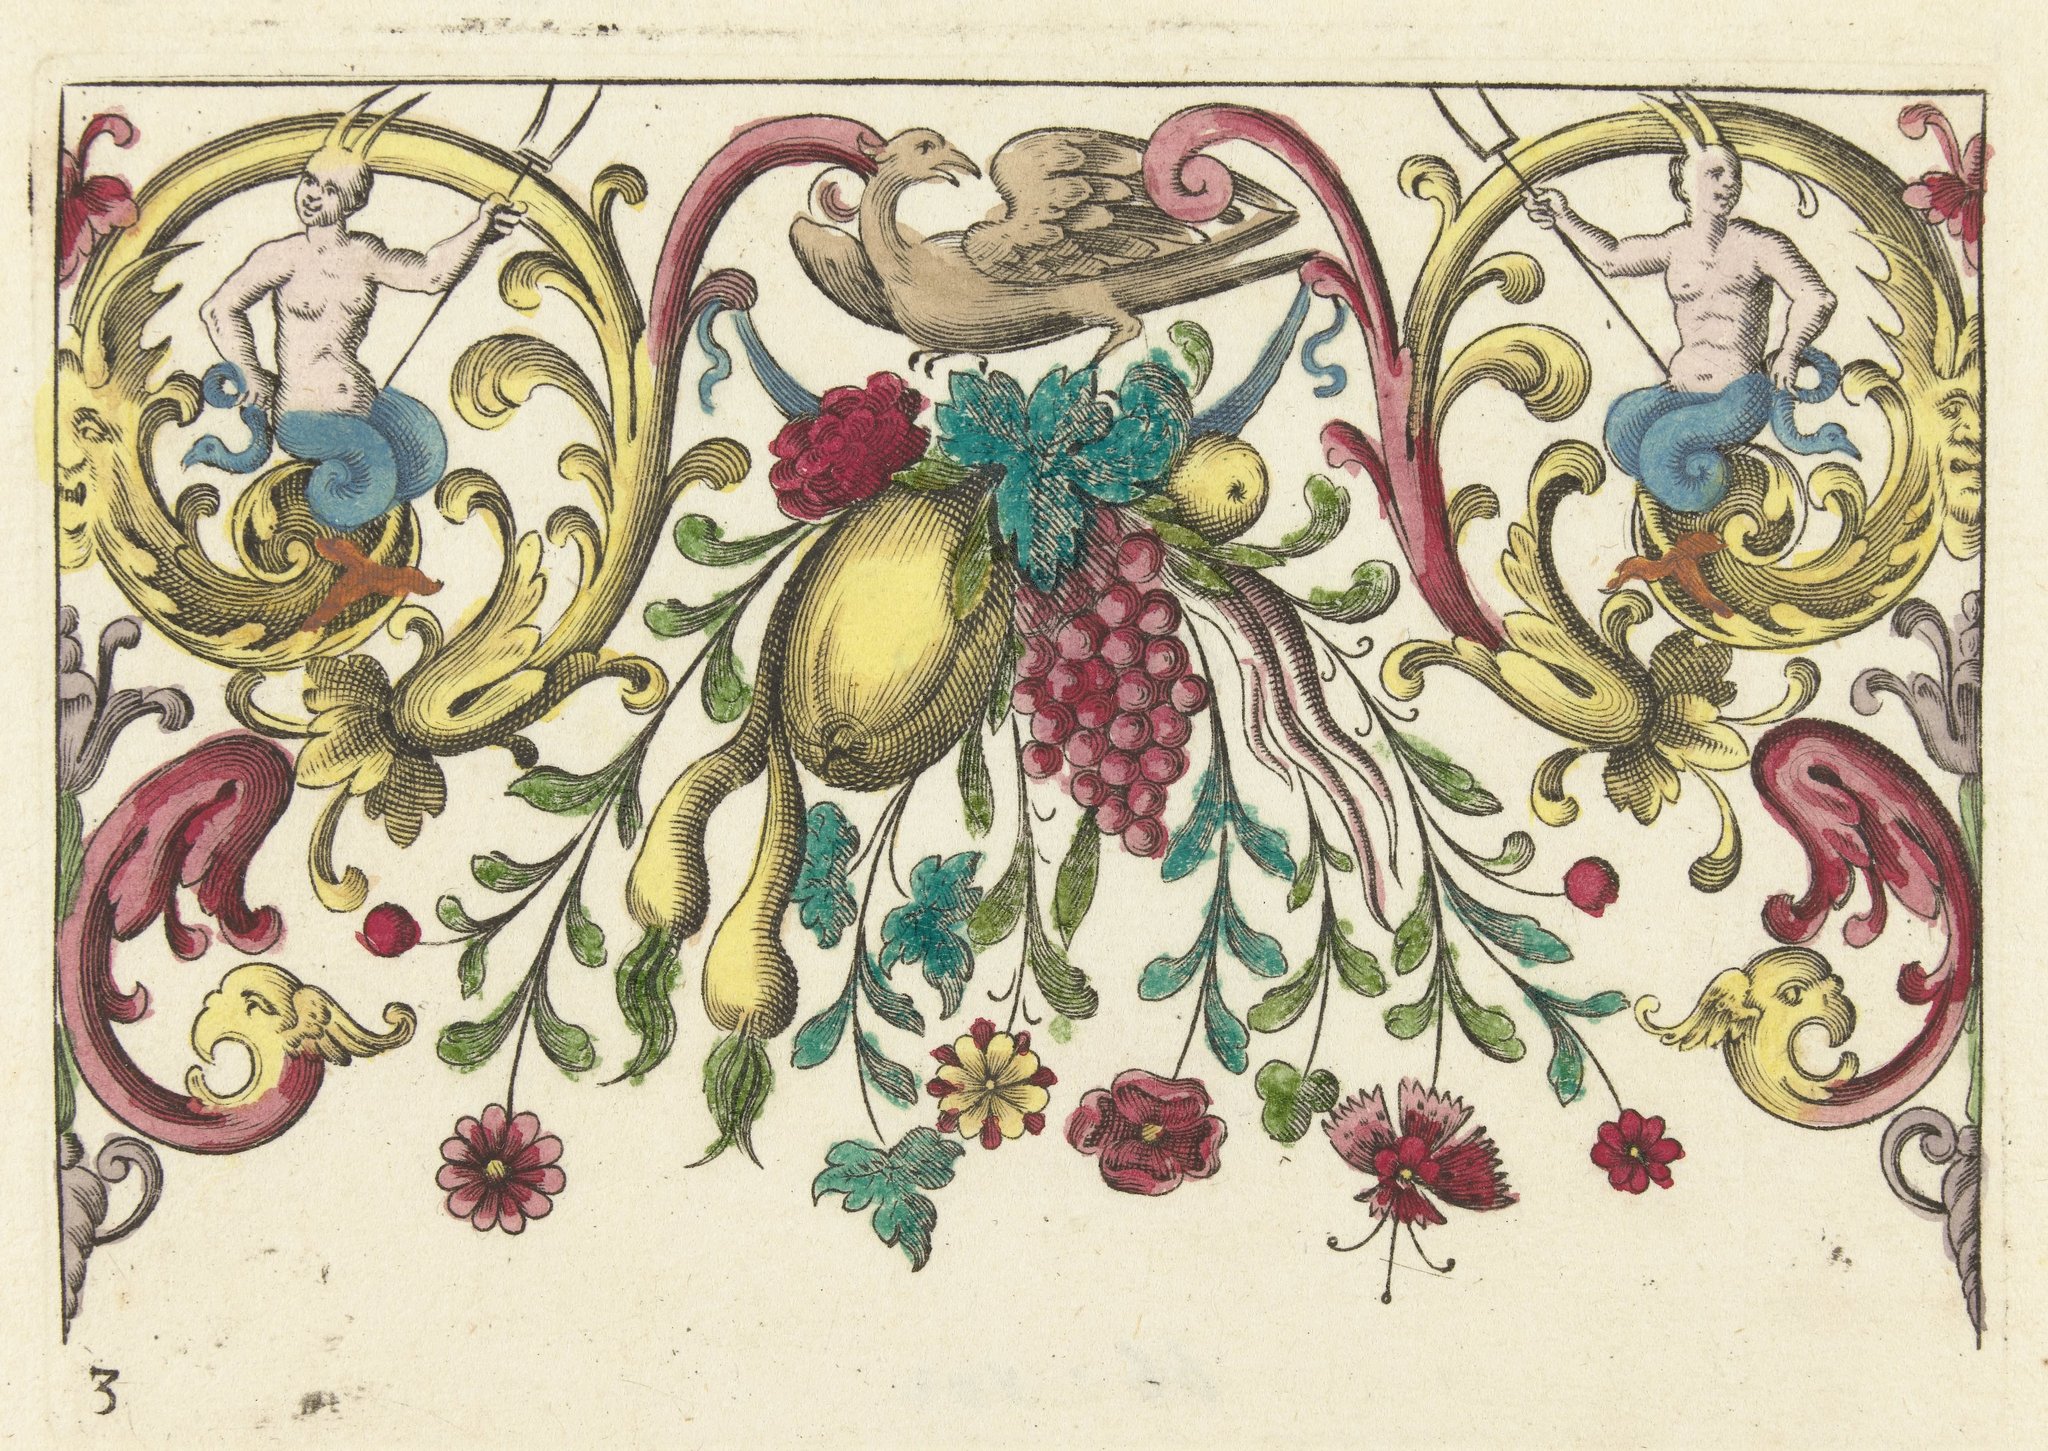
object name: print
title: Guirlande met ondermeer een druiventros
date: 1596-1633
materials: paper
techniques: engraving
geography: germany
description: Een druiventros en een roos hangen tussen twee voluten van bladranken waarop een triton zit. Titelblad uit een serie van 12 bladen, genummerd 1-8.